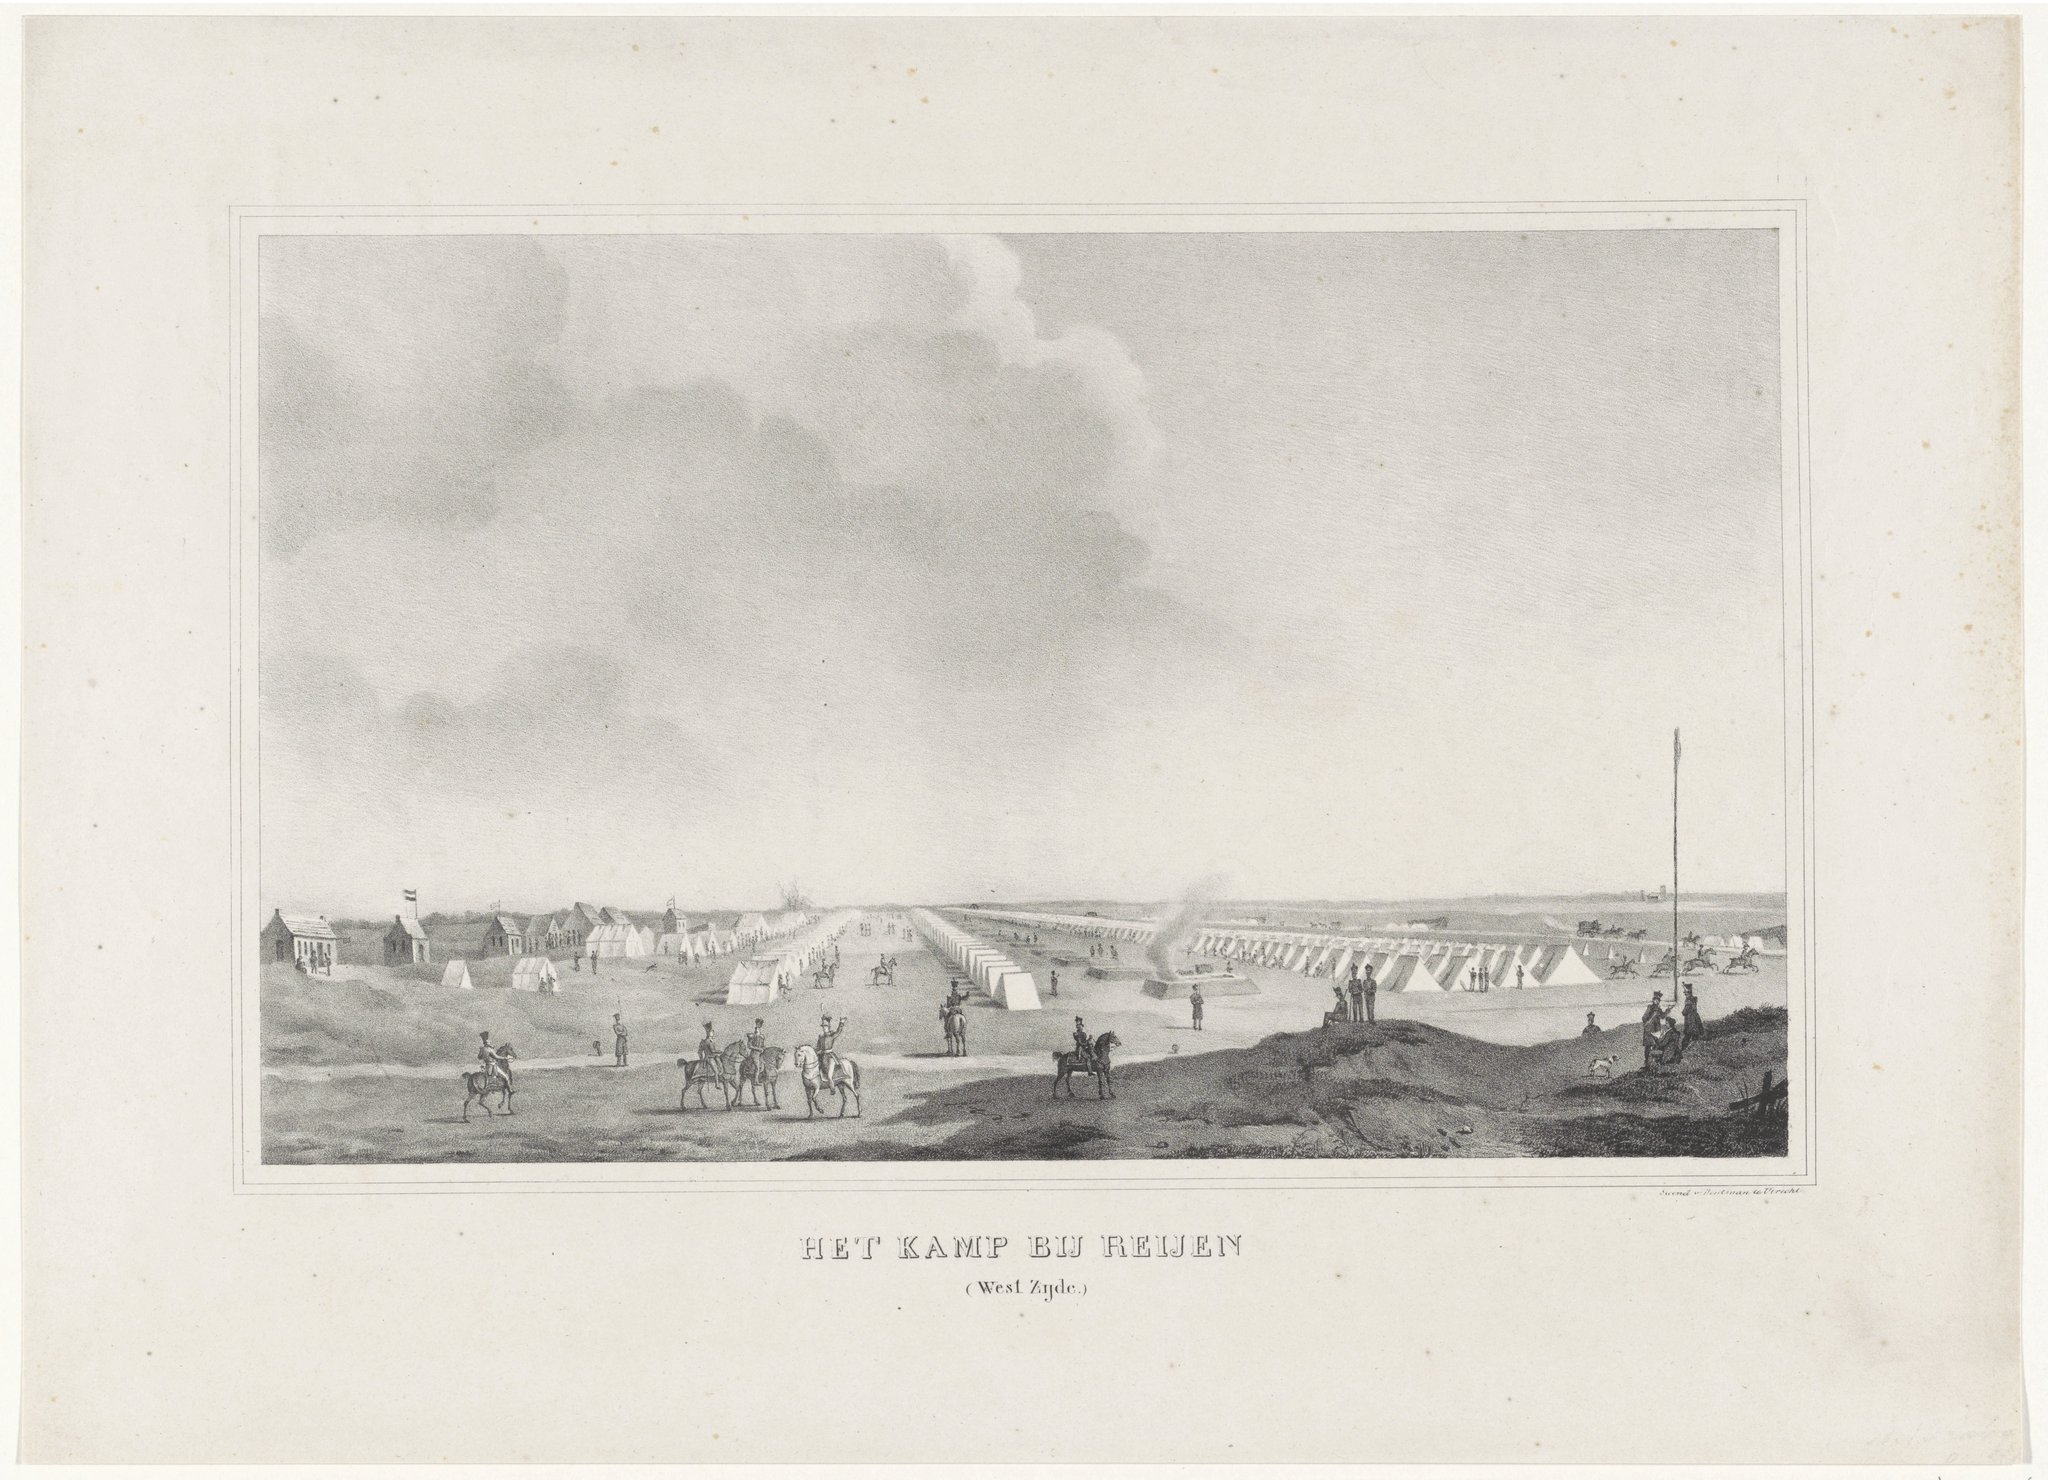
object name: print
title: Het Kamp bij Reijen (West Zijde)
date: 1831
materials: paper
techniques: lithograph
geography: utrecht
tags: (military) camp with tents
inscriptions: collector's mark: Lugt 2228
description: Gezicht op het Nederlandse legerkamp bij Rijen (of Reijen), westzijde, juli 1831.